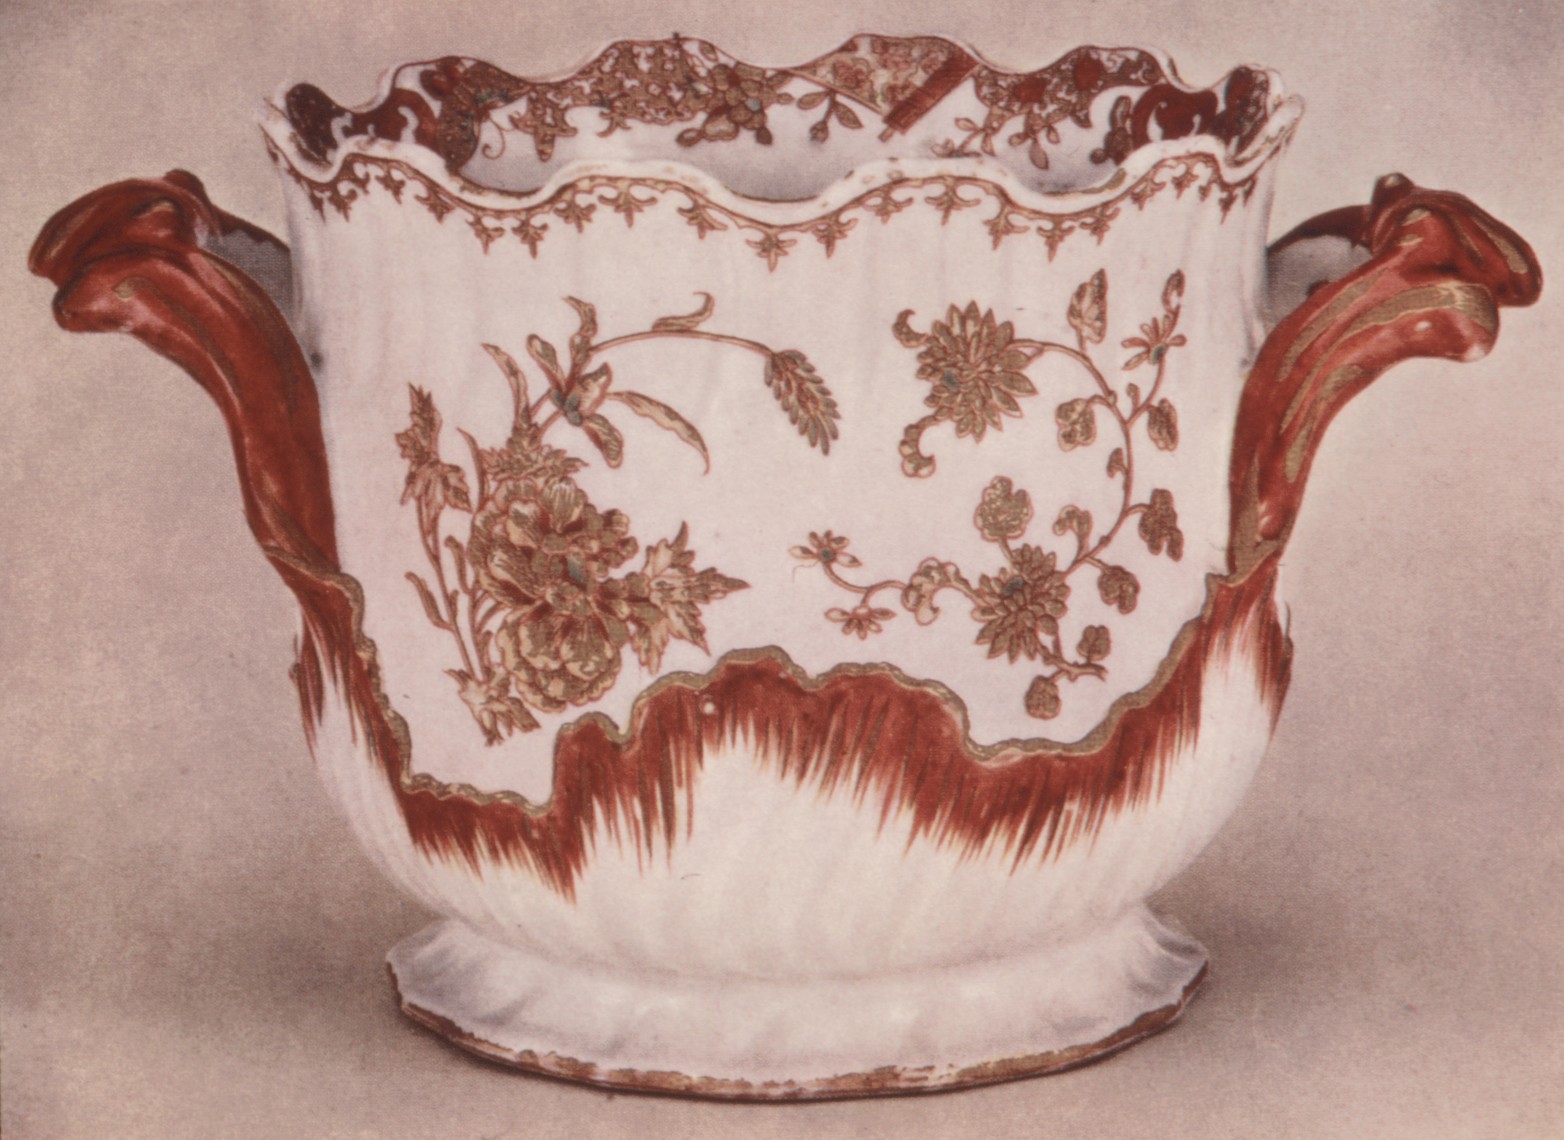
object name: jardinière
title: Two-handled jardinière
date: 1760-1770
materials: hard paste porcelain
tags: flowers